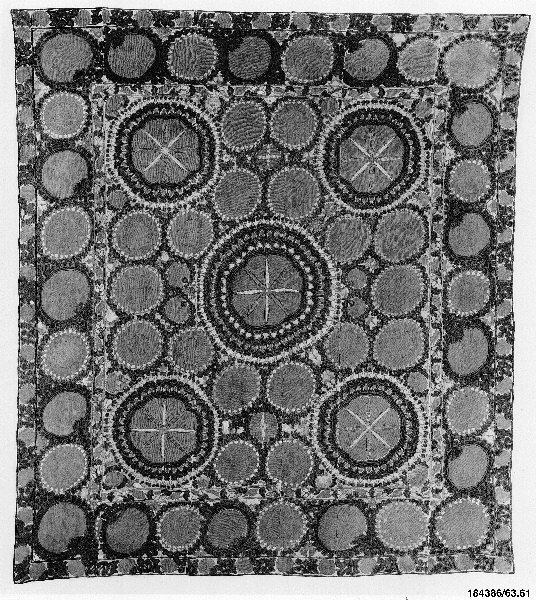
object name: hanging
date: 1701-1900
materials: cotton, linen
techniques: embroidery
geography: uzbekistan